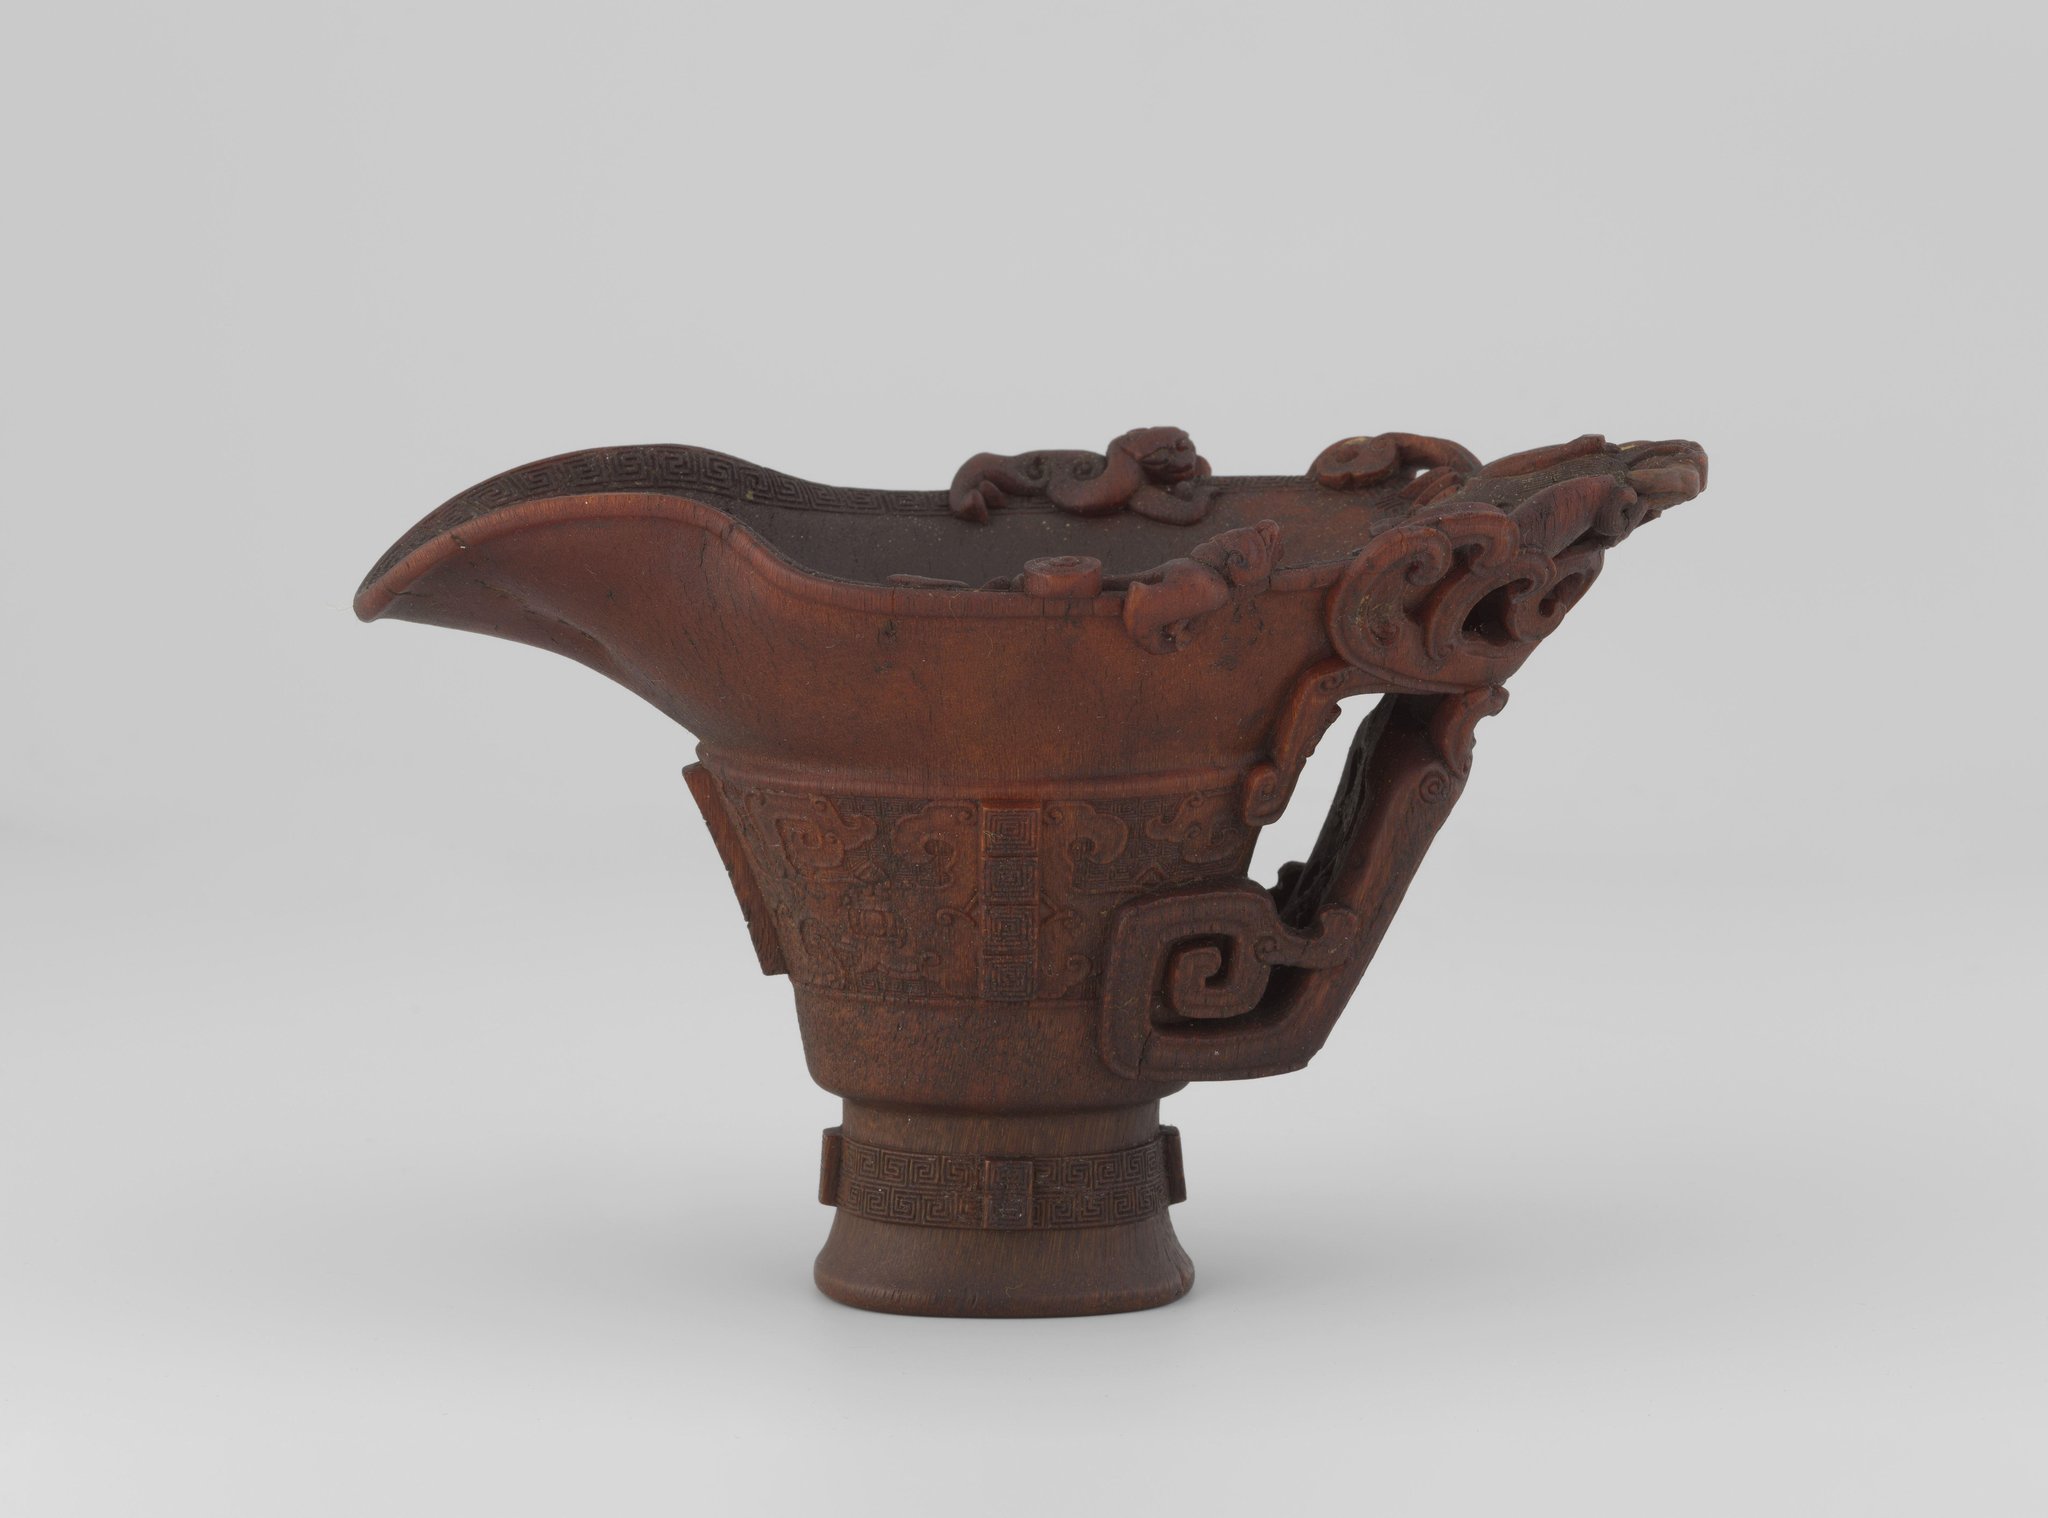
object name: bowl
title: Carved rhino horn cup imitating bronze object with decorations of dragons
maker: Anonymous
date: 1700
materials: rhinoceros horn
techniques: cutting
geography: china